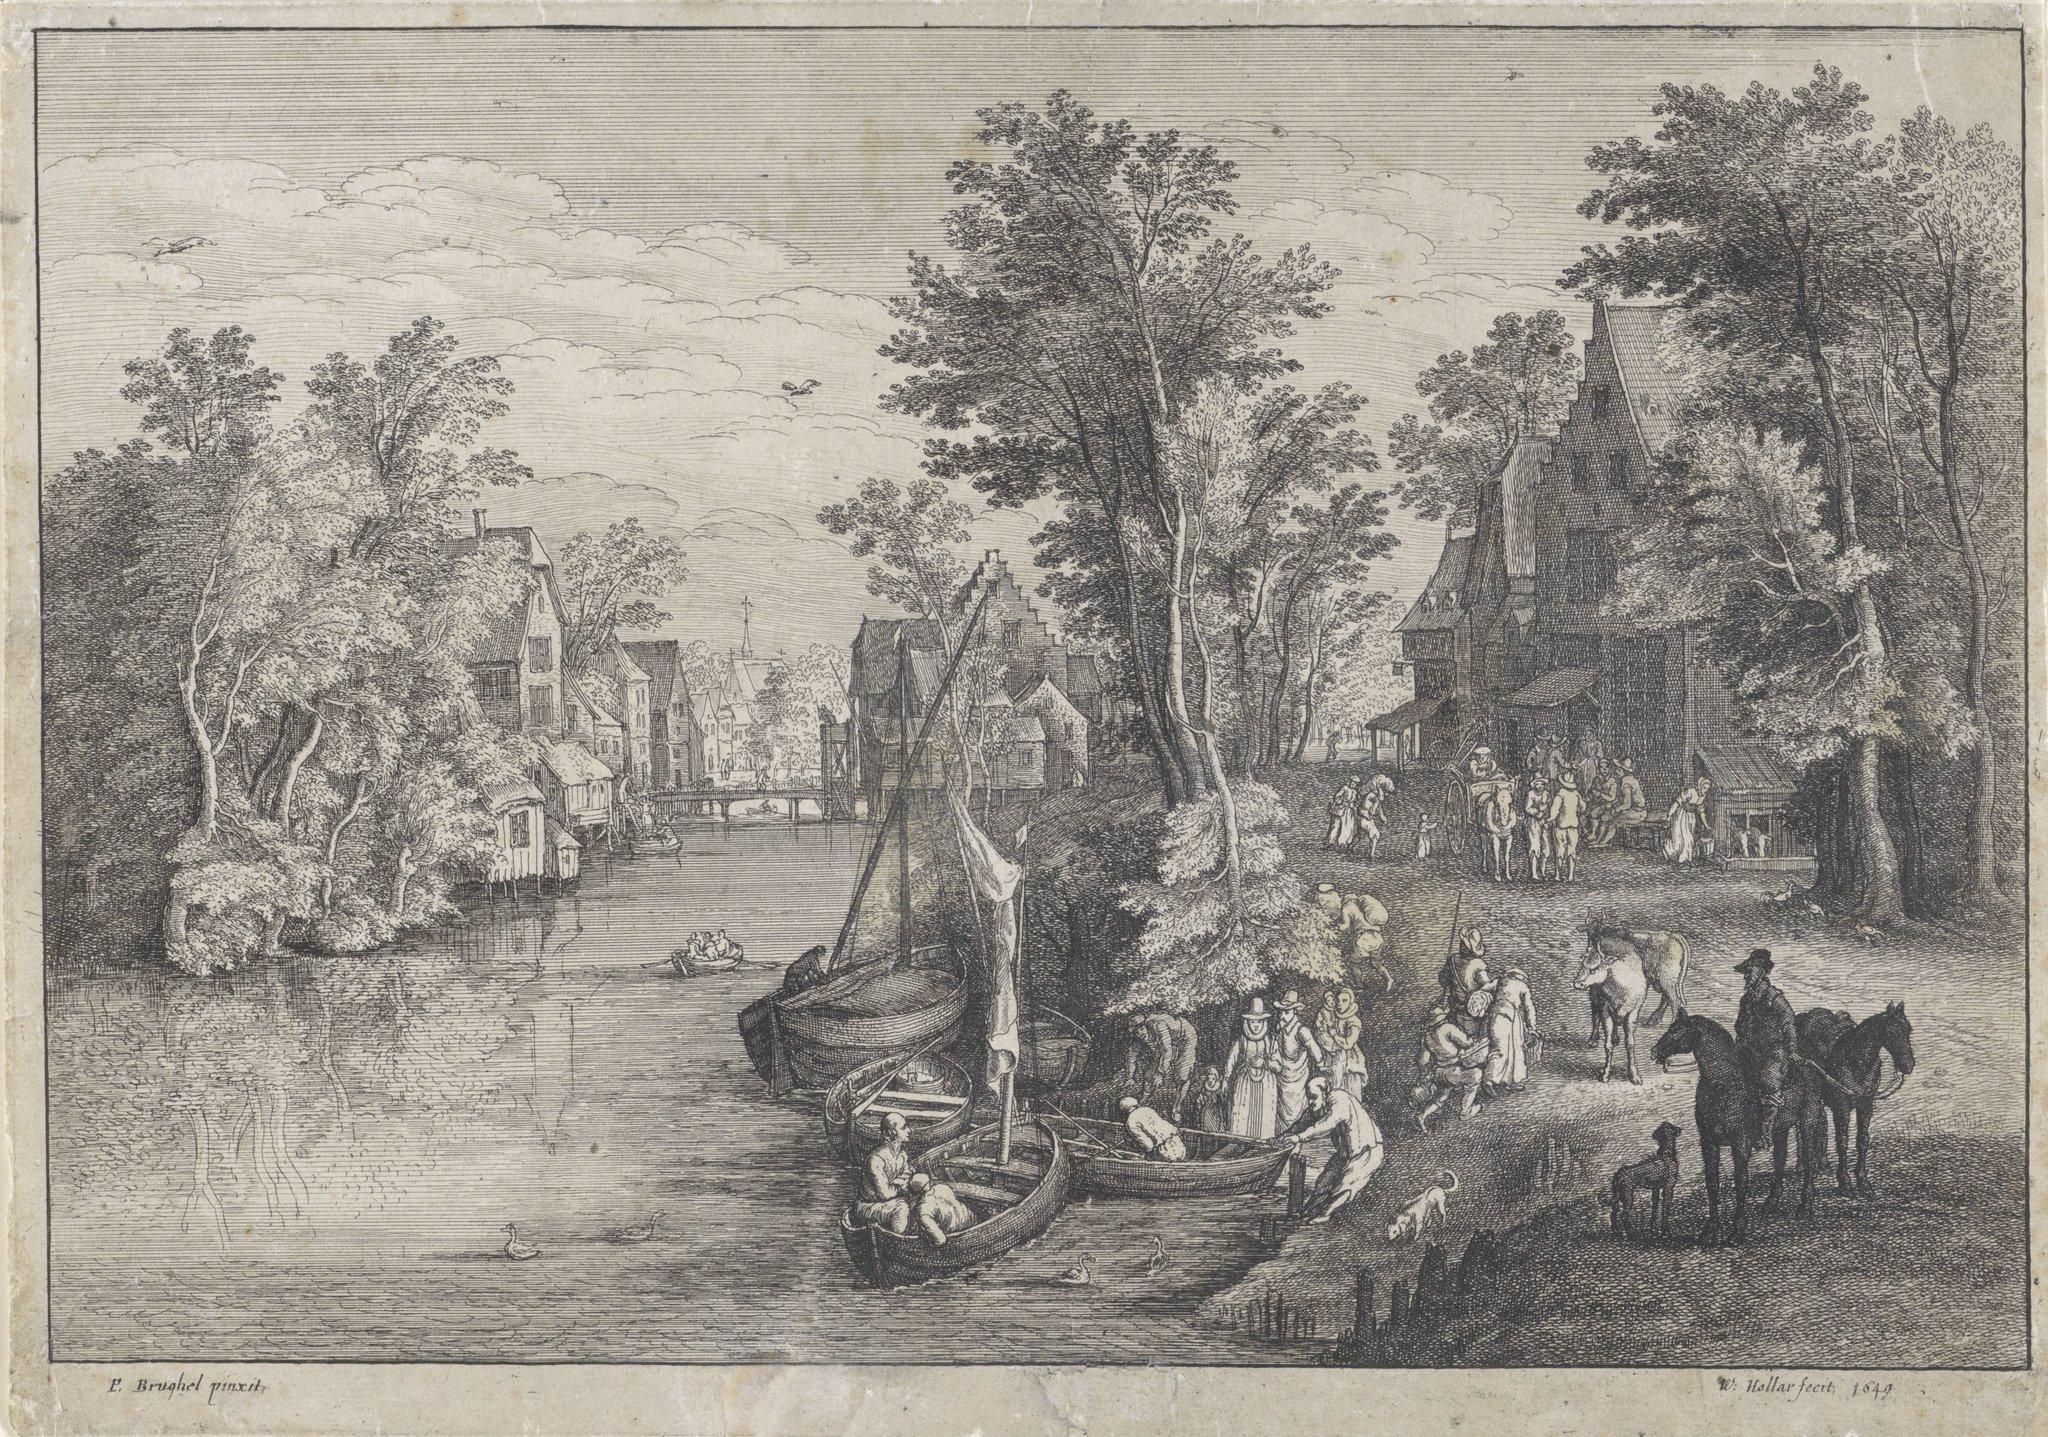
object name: print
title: Dorpsgezicht met kleine veerboot aan de rivier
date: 1649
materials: paper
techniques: etching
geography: antwerp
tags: village, ferry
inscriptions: collector's mark: Lugt 240